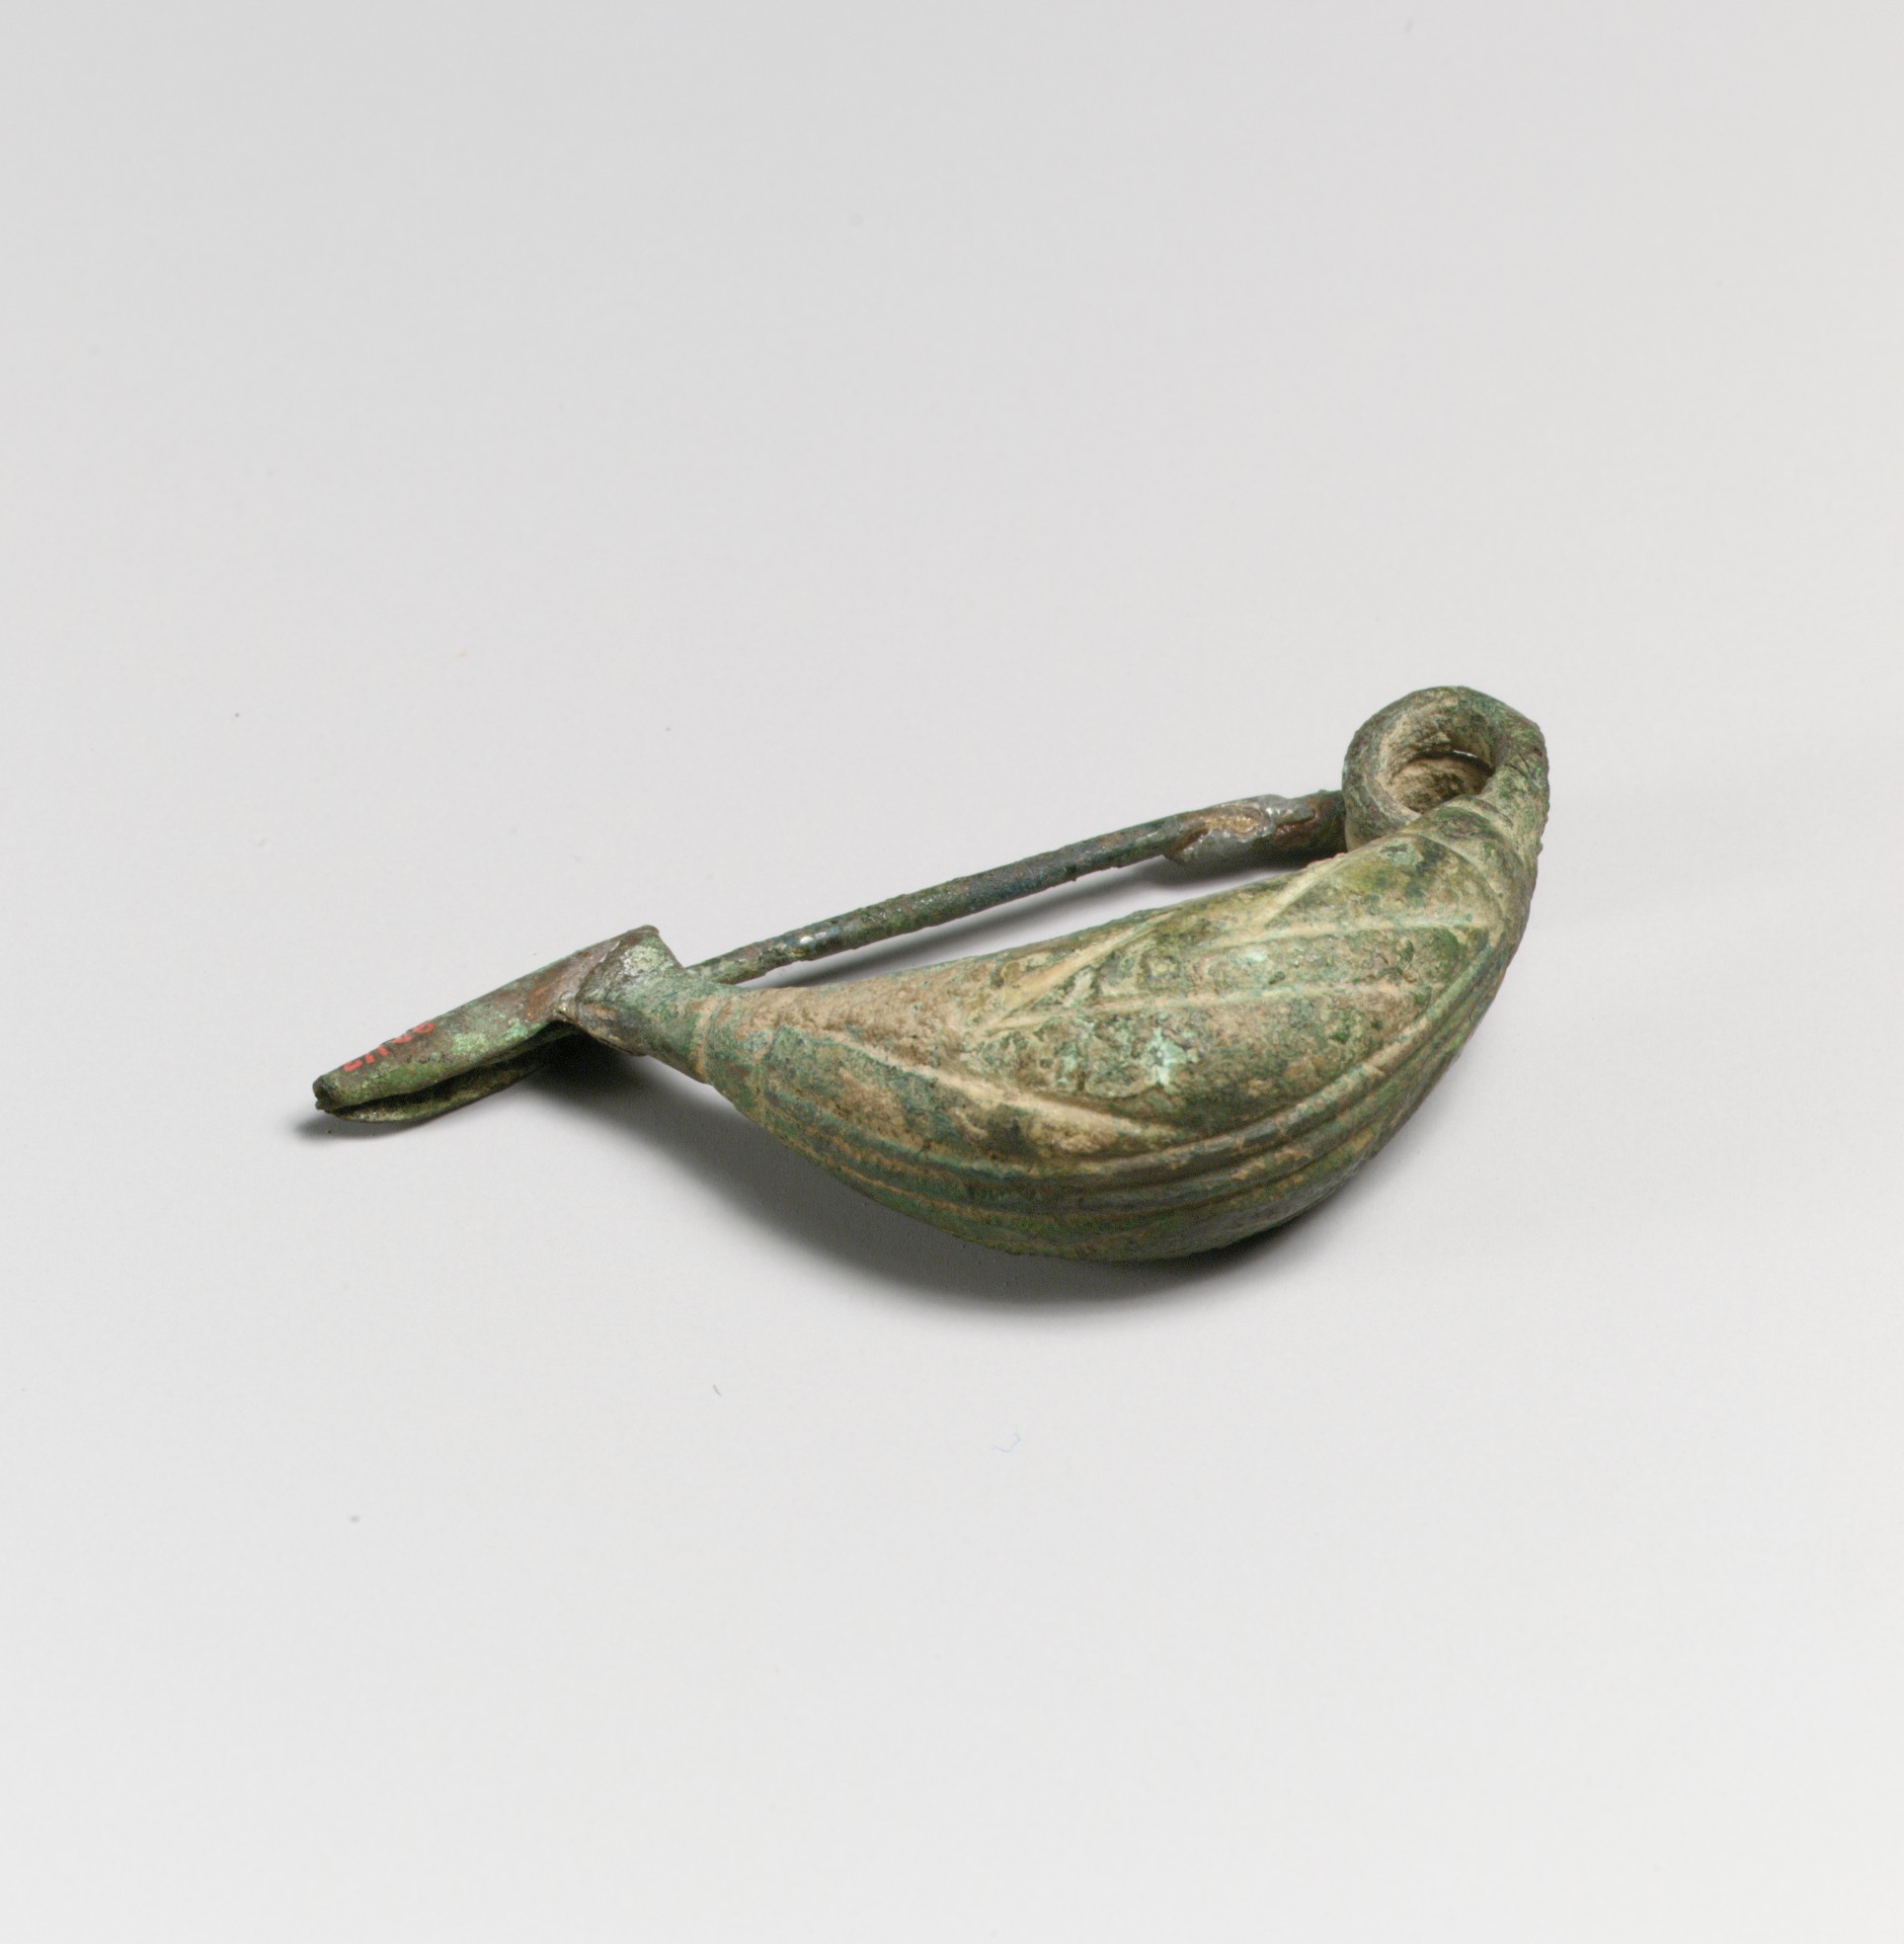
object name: fibula, boat shaped type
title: Fibula, boat-shaped type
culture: italic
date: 800-701 BCE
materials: bronze